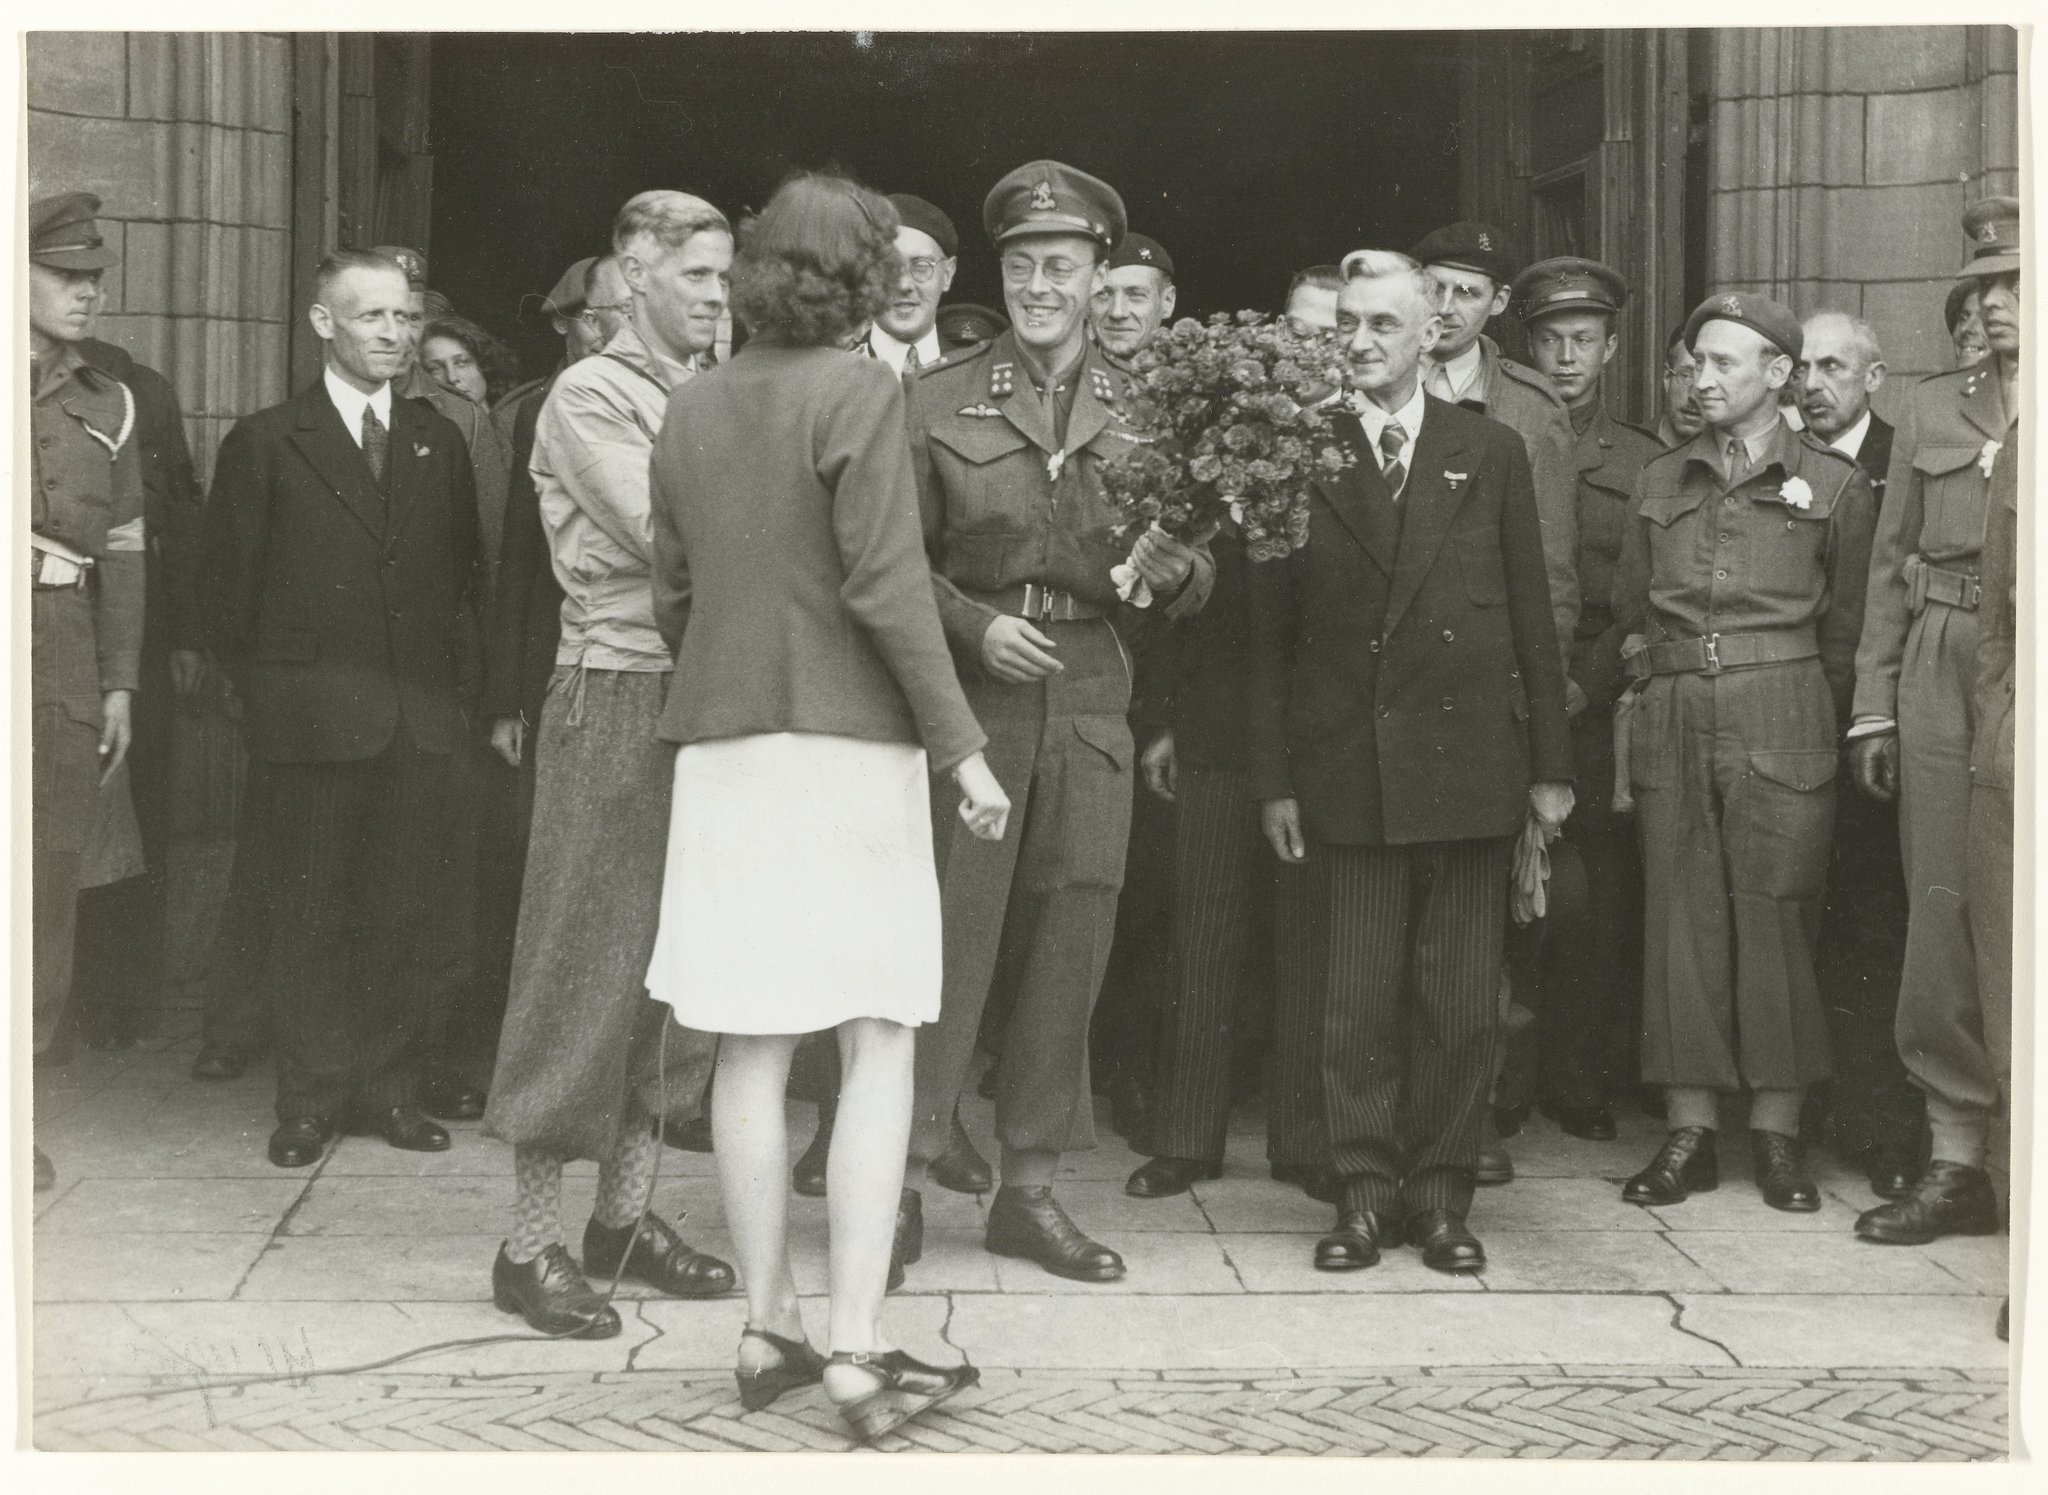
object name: photograph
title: Prins Bernhard op zijn verjaardag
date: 1906-1945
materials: photographic support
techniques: photography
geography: delft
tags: utrecht, bernhard (prins der nederlanden), delft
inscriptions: stamp: ‘COPYRIGHT / 'ANEFO' / ALGEMEEN NEDERLANDSCH FOTOBUREAU’, inscription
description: Prins Bernhard op zijn verjaardag, 29 juni 1945, met militairen van Binnenlandse Strijdkrachten. Hij maakte een tocht langs diverse steden. Bij het verlaten van de grote kerk te Delft worden hem door leden van de BS bloemen aangeboden.